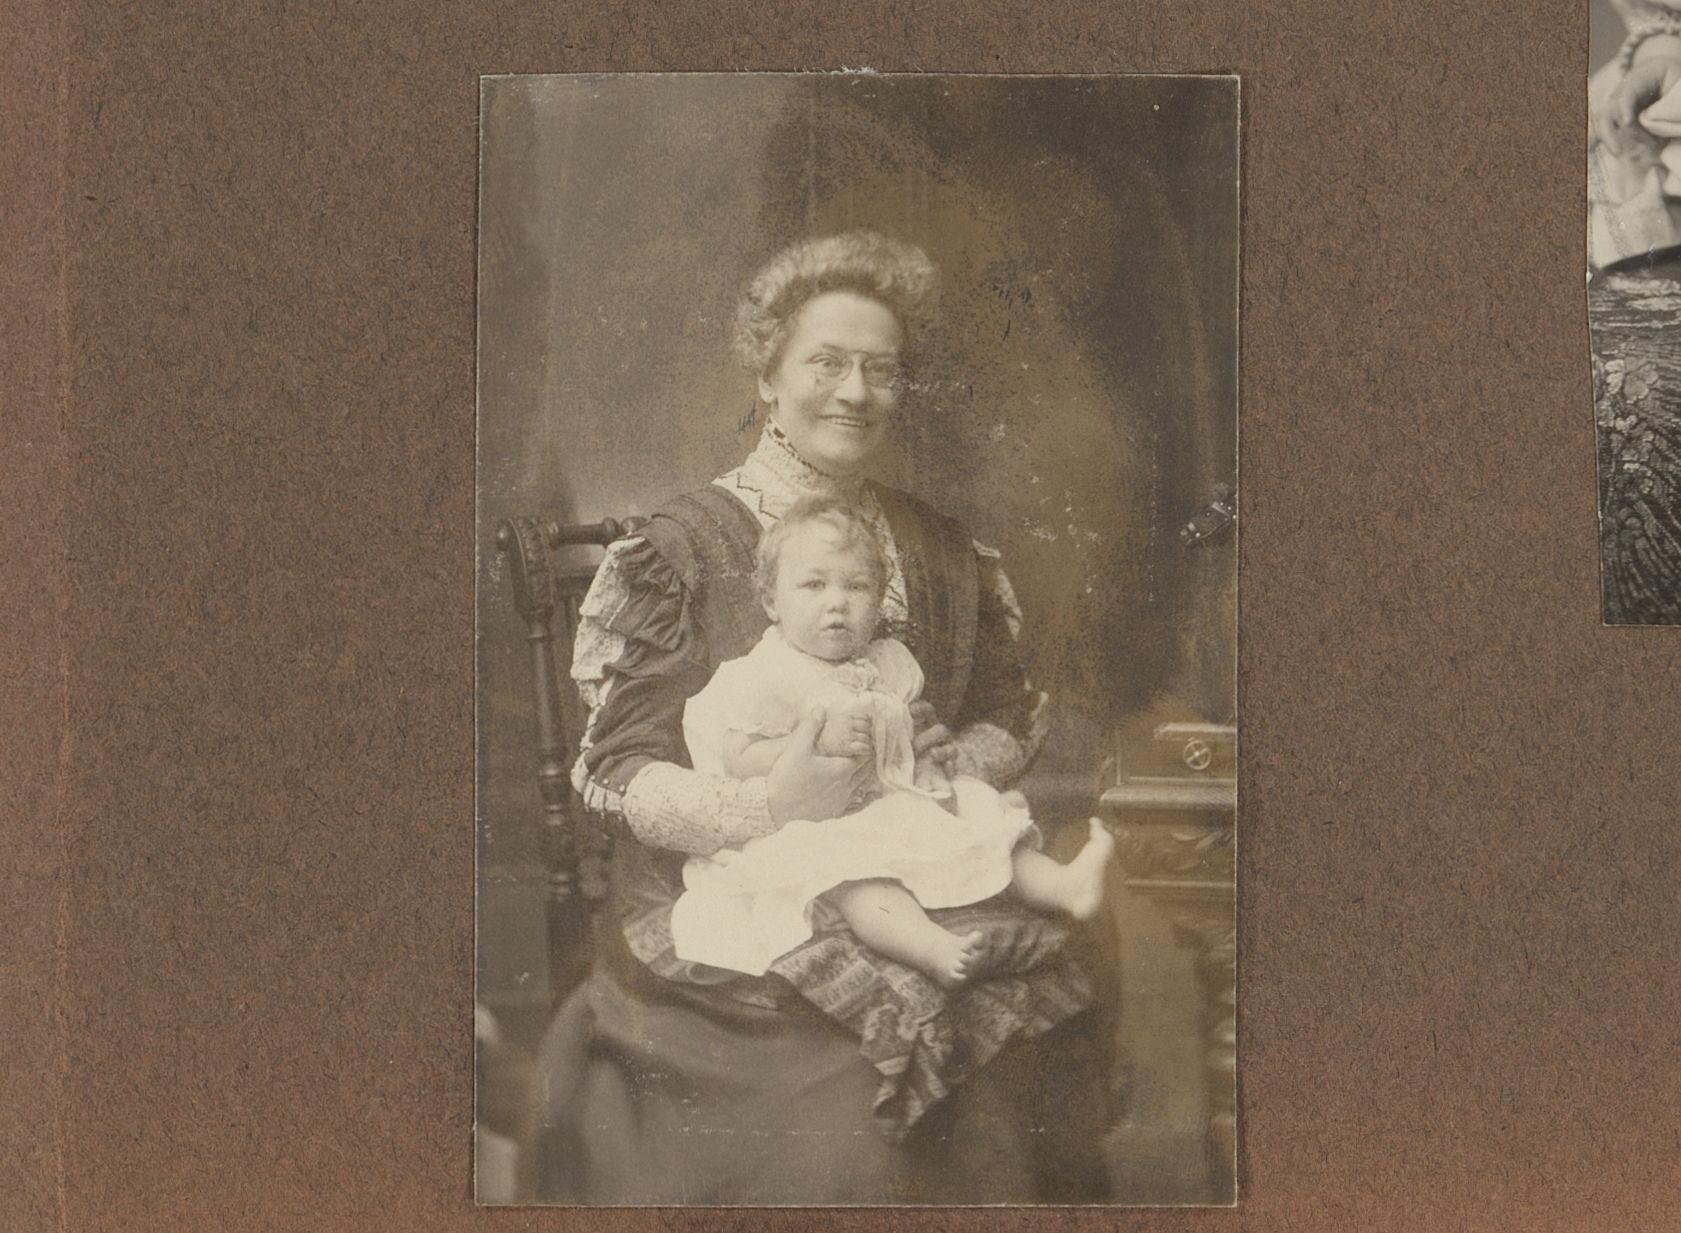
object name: photograph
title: Vrouw met jong kind op schoot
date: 1870-1920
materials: photographic support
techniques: photography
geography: amsterdam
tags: netherlands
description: Foto op bruin albumblad 43 van familiealbum van Alphons Diepenbrock.